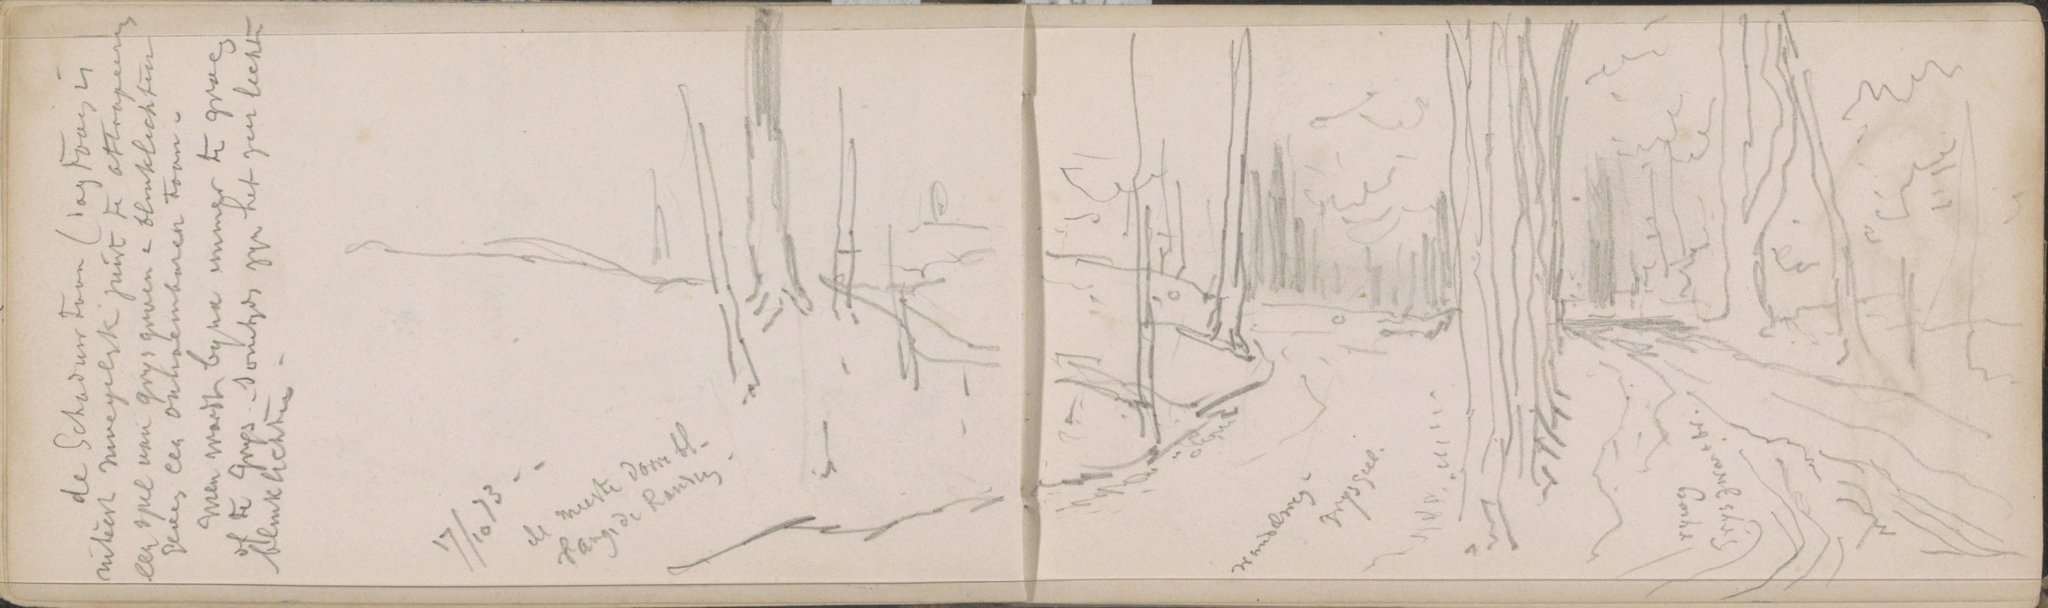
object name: sketchbook leaf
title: Jachtgezelschap met honden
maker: johannes tavenraat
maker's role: draughtsman, painter, print maker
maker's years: 1809-1881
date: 1873-1876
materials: ink, paper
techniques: pen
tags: hunter, resting - bb - out of doors, dog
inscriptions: kleurnotitie, handgeschreven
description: Vermoedelijk rusten de mannen. Zij roken, zitten en liggen bij een boom. Blad 8 verso uit een schetsboek met 46 bladen.